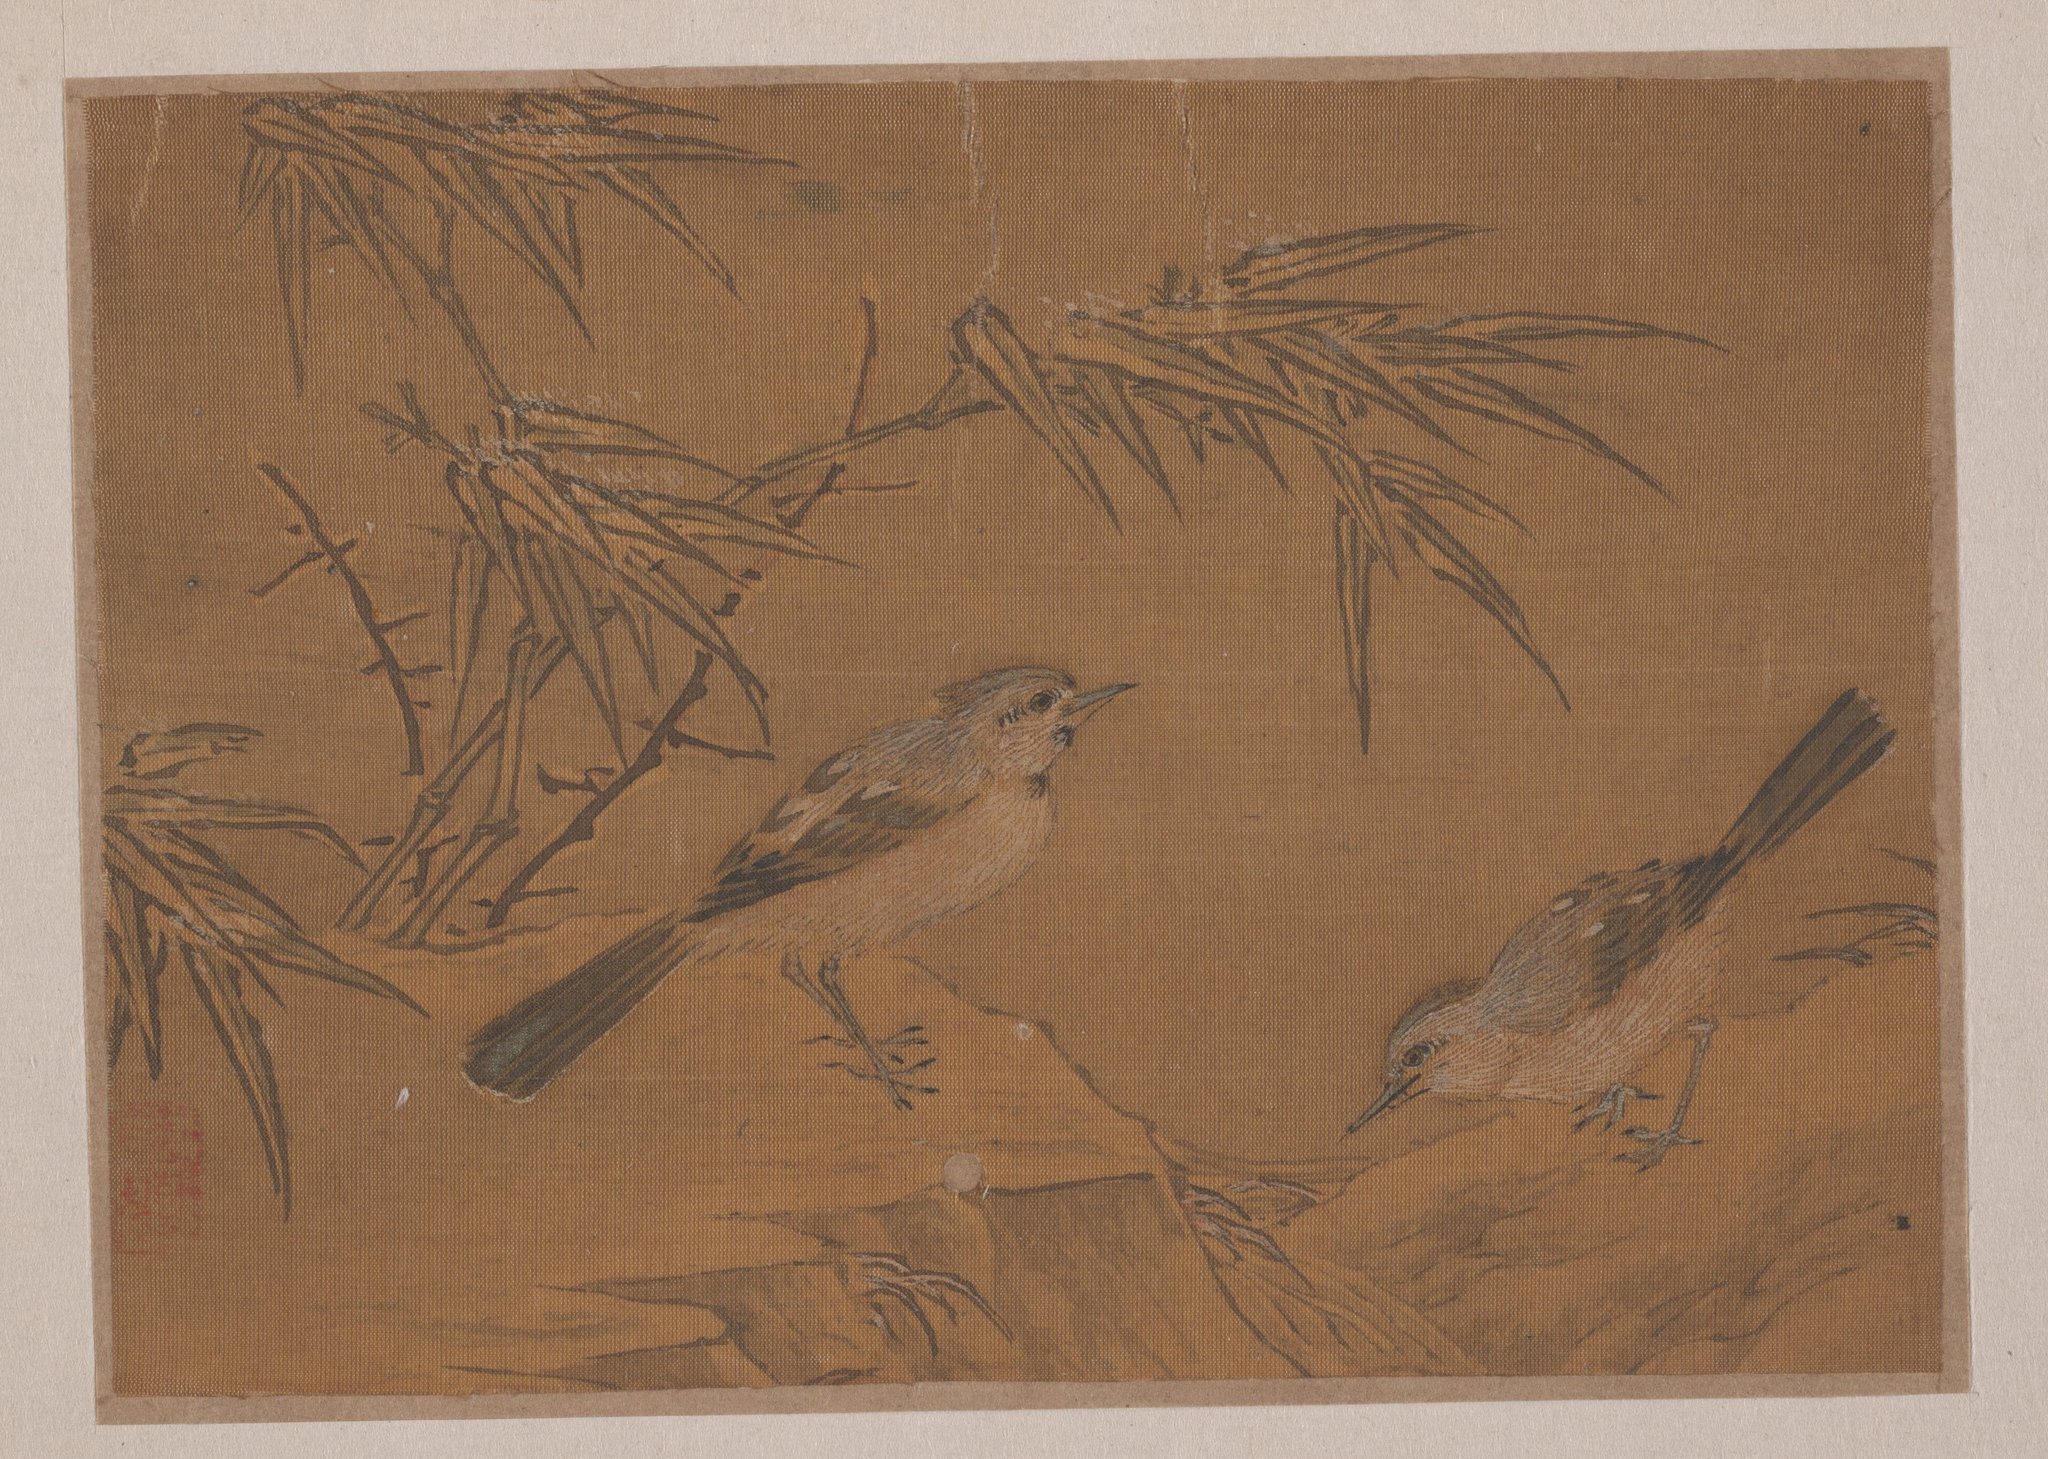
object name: album leaf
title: Two Birds and Bamboo Plant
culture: chinese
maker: unidentified artist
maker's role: artist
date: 1368-1911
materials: ink, silk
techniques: painting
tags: birds,bamboo